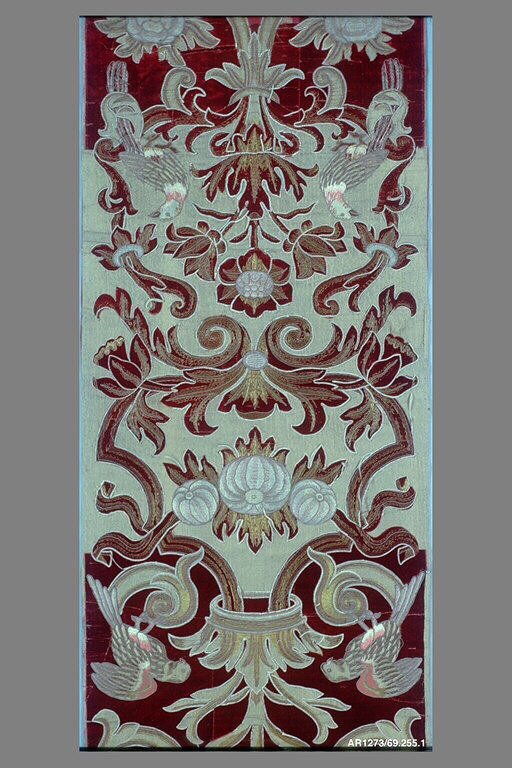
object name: panel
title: Pair of vertical panels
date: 1601-1633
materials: metal thread, silk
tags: birds,flowers